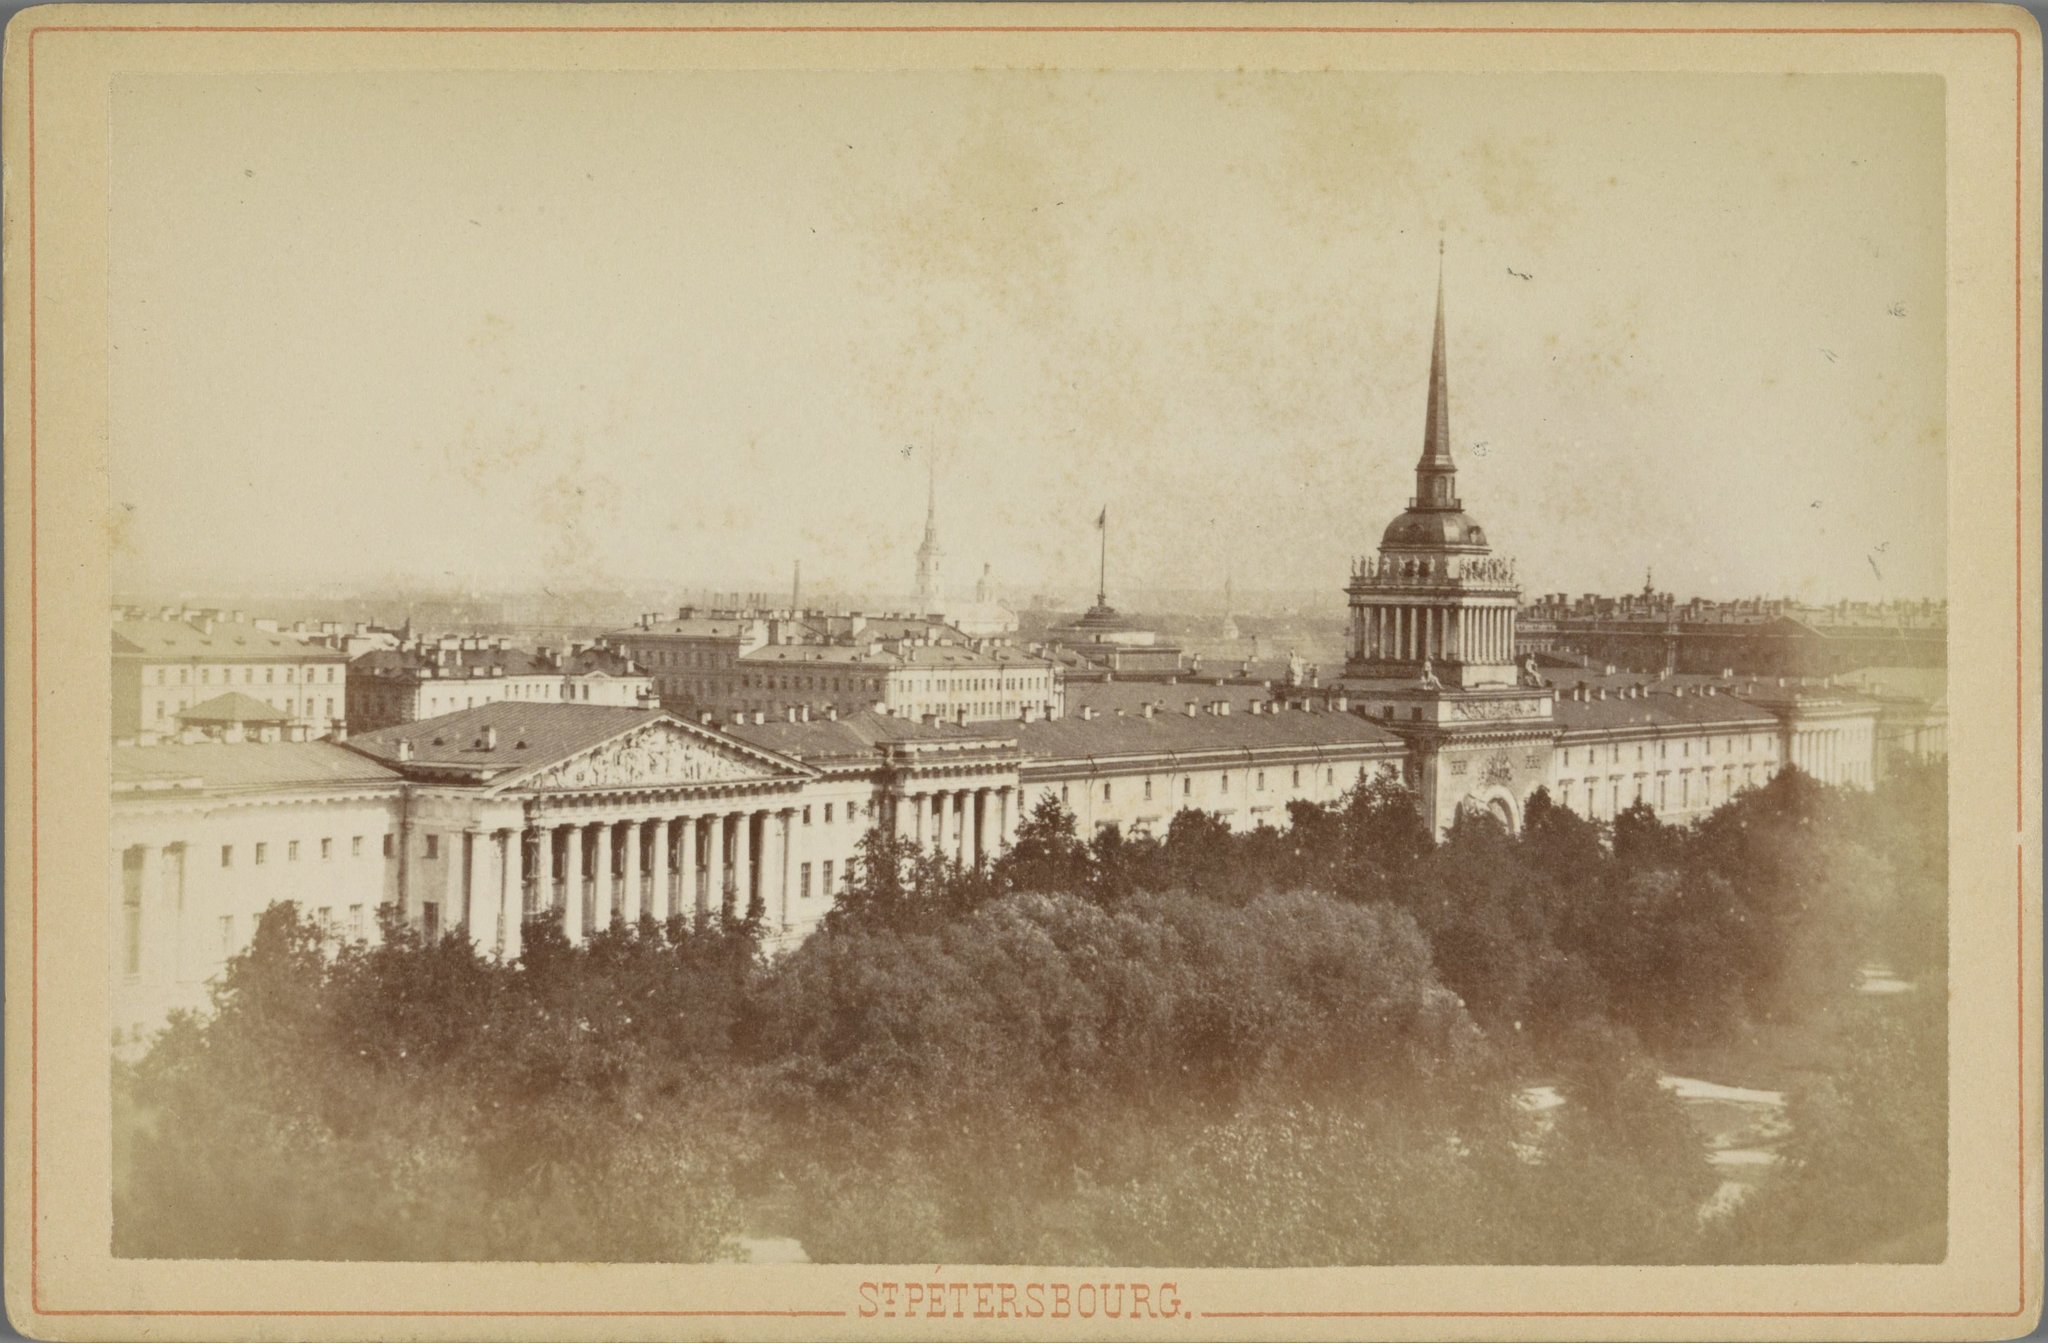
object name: cabinet photograph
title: Gezicht op het gebouw van de Admiraliteit in Sint-Petersburg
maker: joseph daziaro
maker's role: publisher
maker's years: 1831-1892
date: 1880-1900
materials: cardboard, photographic support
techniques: albumen print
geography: sint-petersburg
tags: tower, clock tower ~ monumental adornment, façade (of house or building)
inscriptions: inscription: ‘L'amirauté’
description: Onderdeel van Fotoalbum met opnames van Sint-Petersburg.